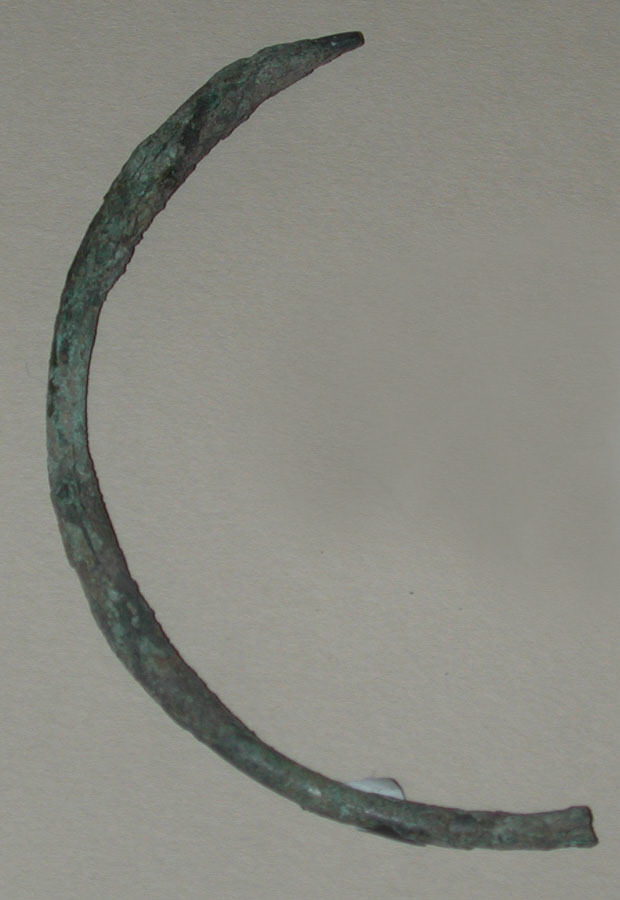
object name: hook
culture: indian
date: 1500-500 BCE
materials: copper